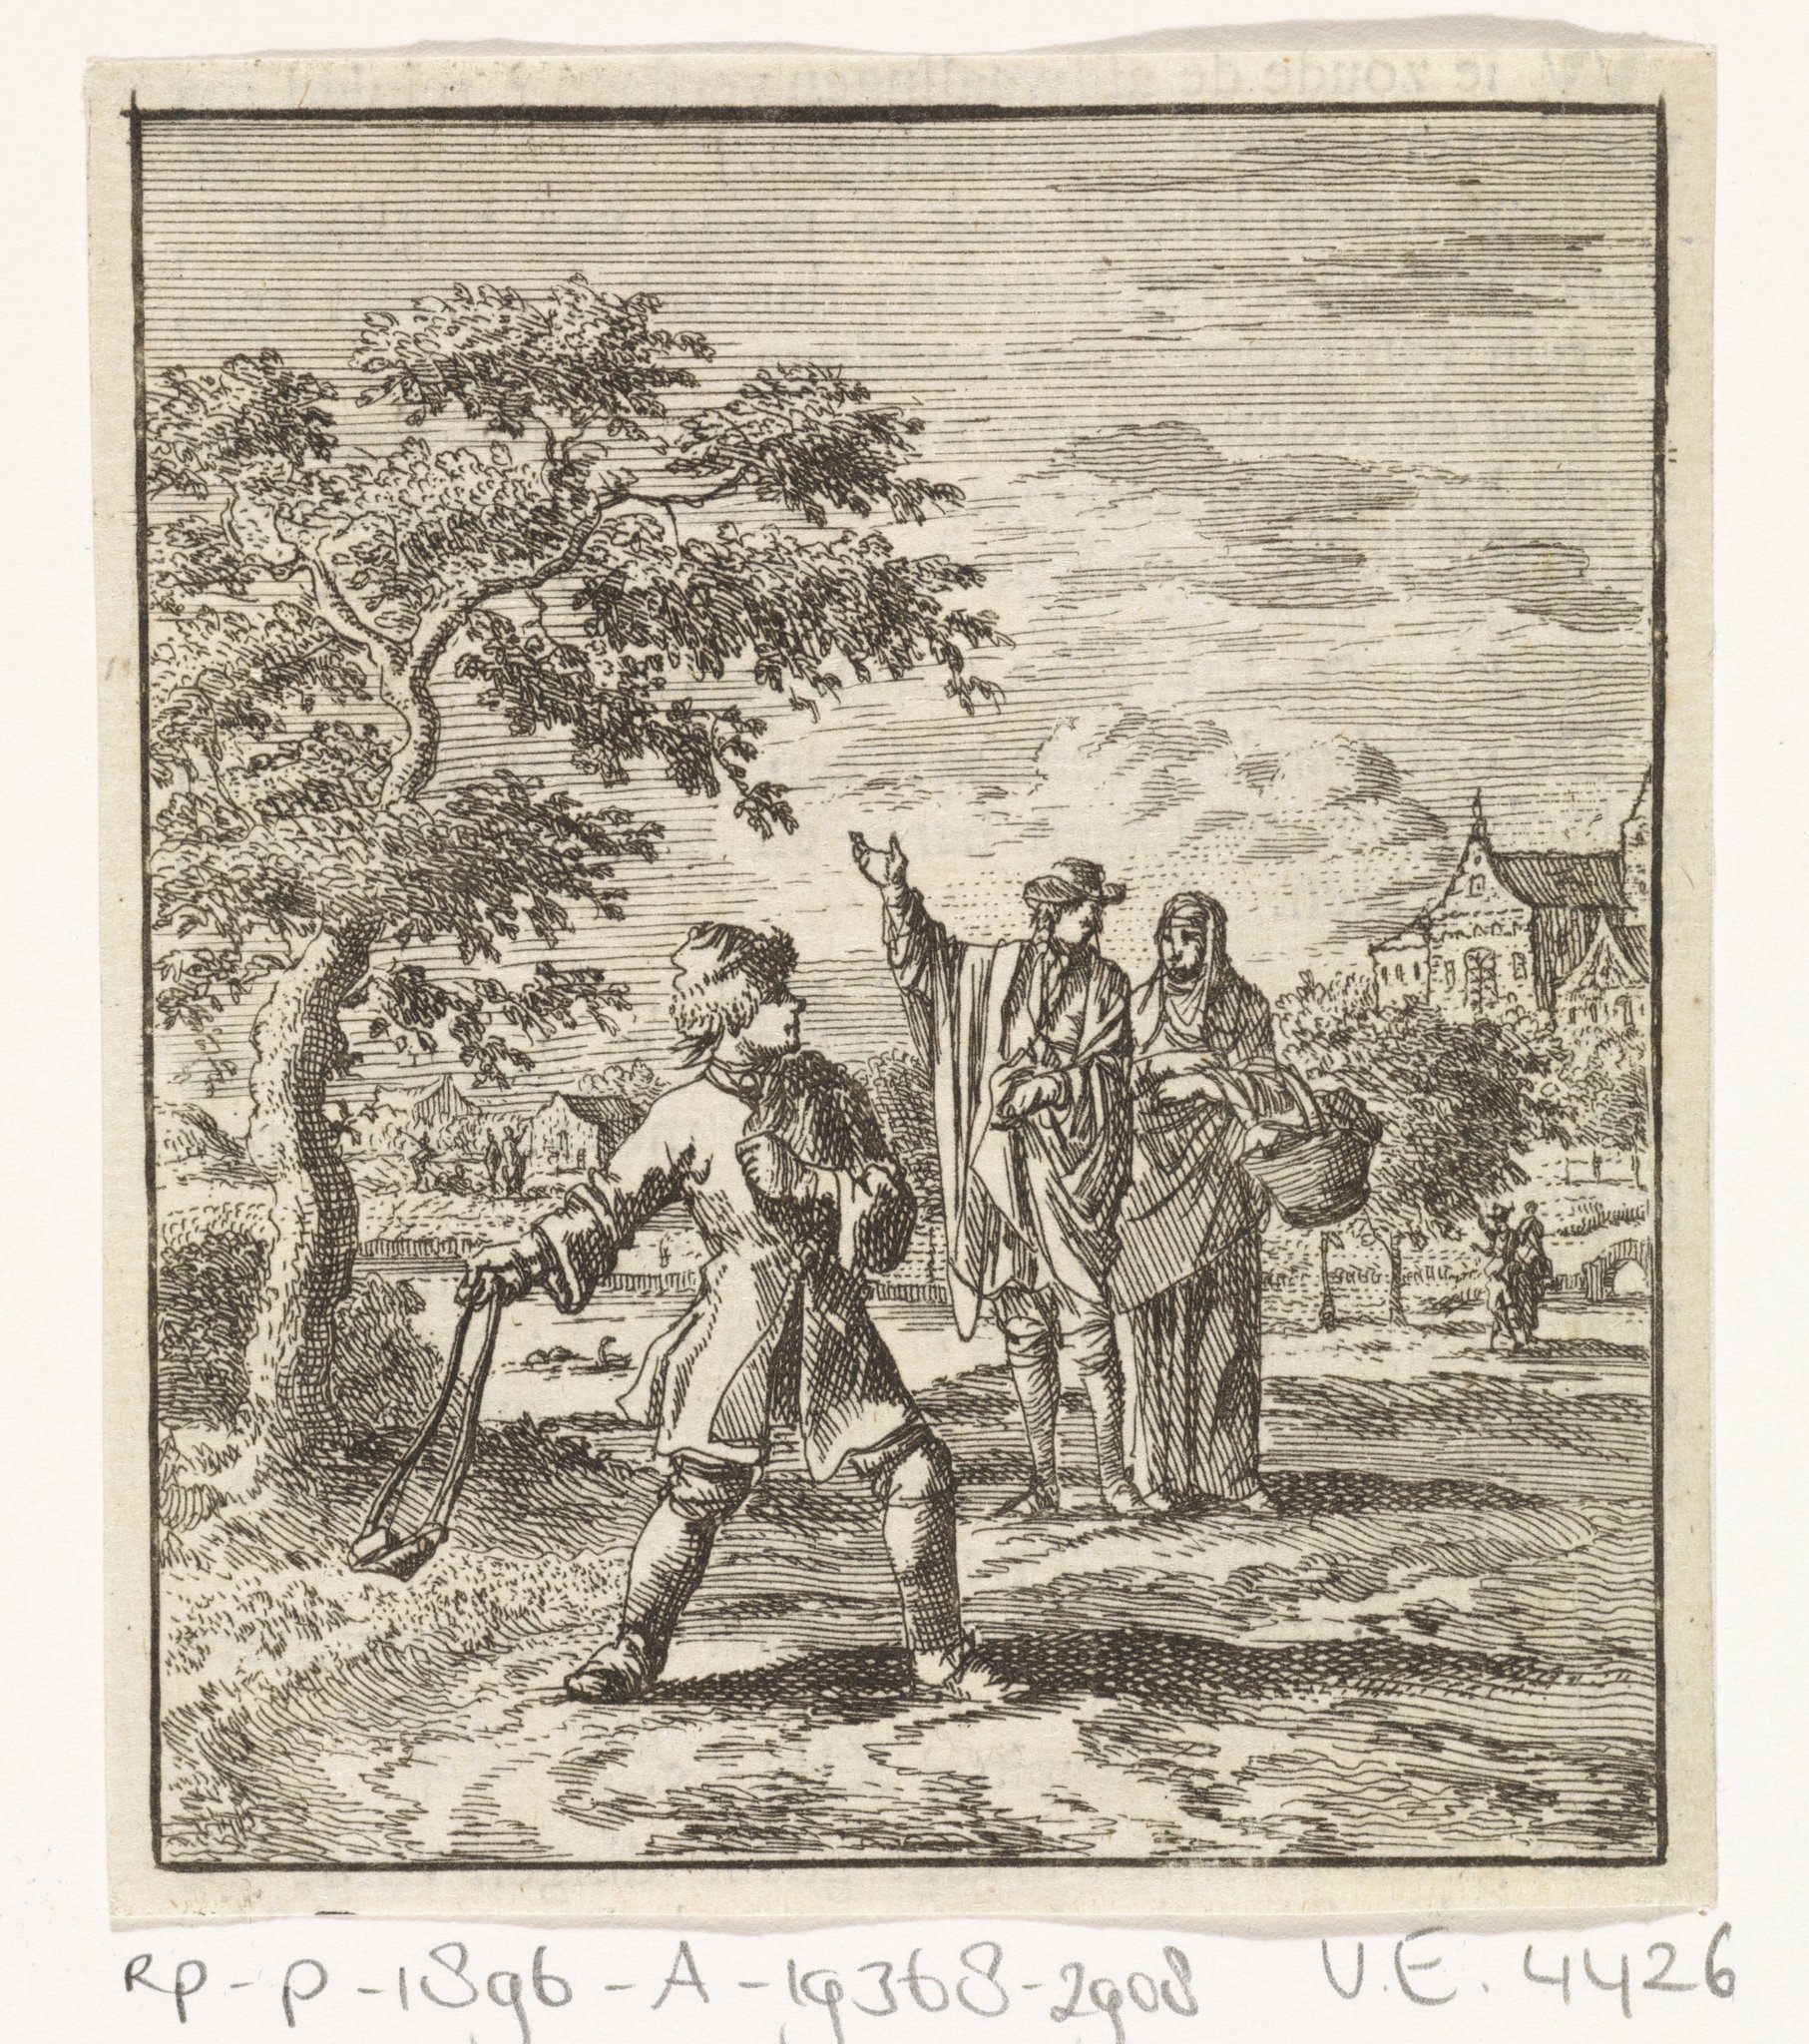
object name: print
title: De Slinger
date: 1712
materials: paper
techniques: etching, letterpress printing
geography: amsterdam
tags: throwing stones (throwing game) (+ out of doors (sports, games, etc.))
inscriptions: collector's mark: Lugt 2228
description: Illustratie uit: Luyken, Jan. Des menschen begin, midden en einde. Amsterdam: Wed. Pieter Arentsz II en Cornelis van der Sys, 1712, p. 85.